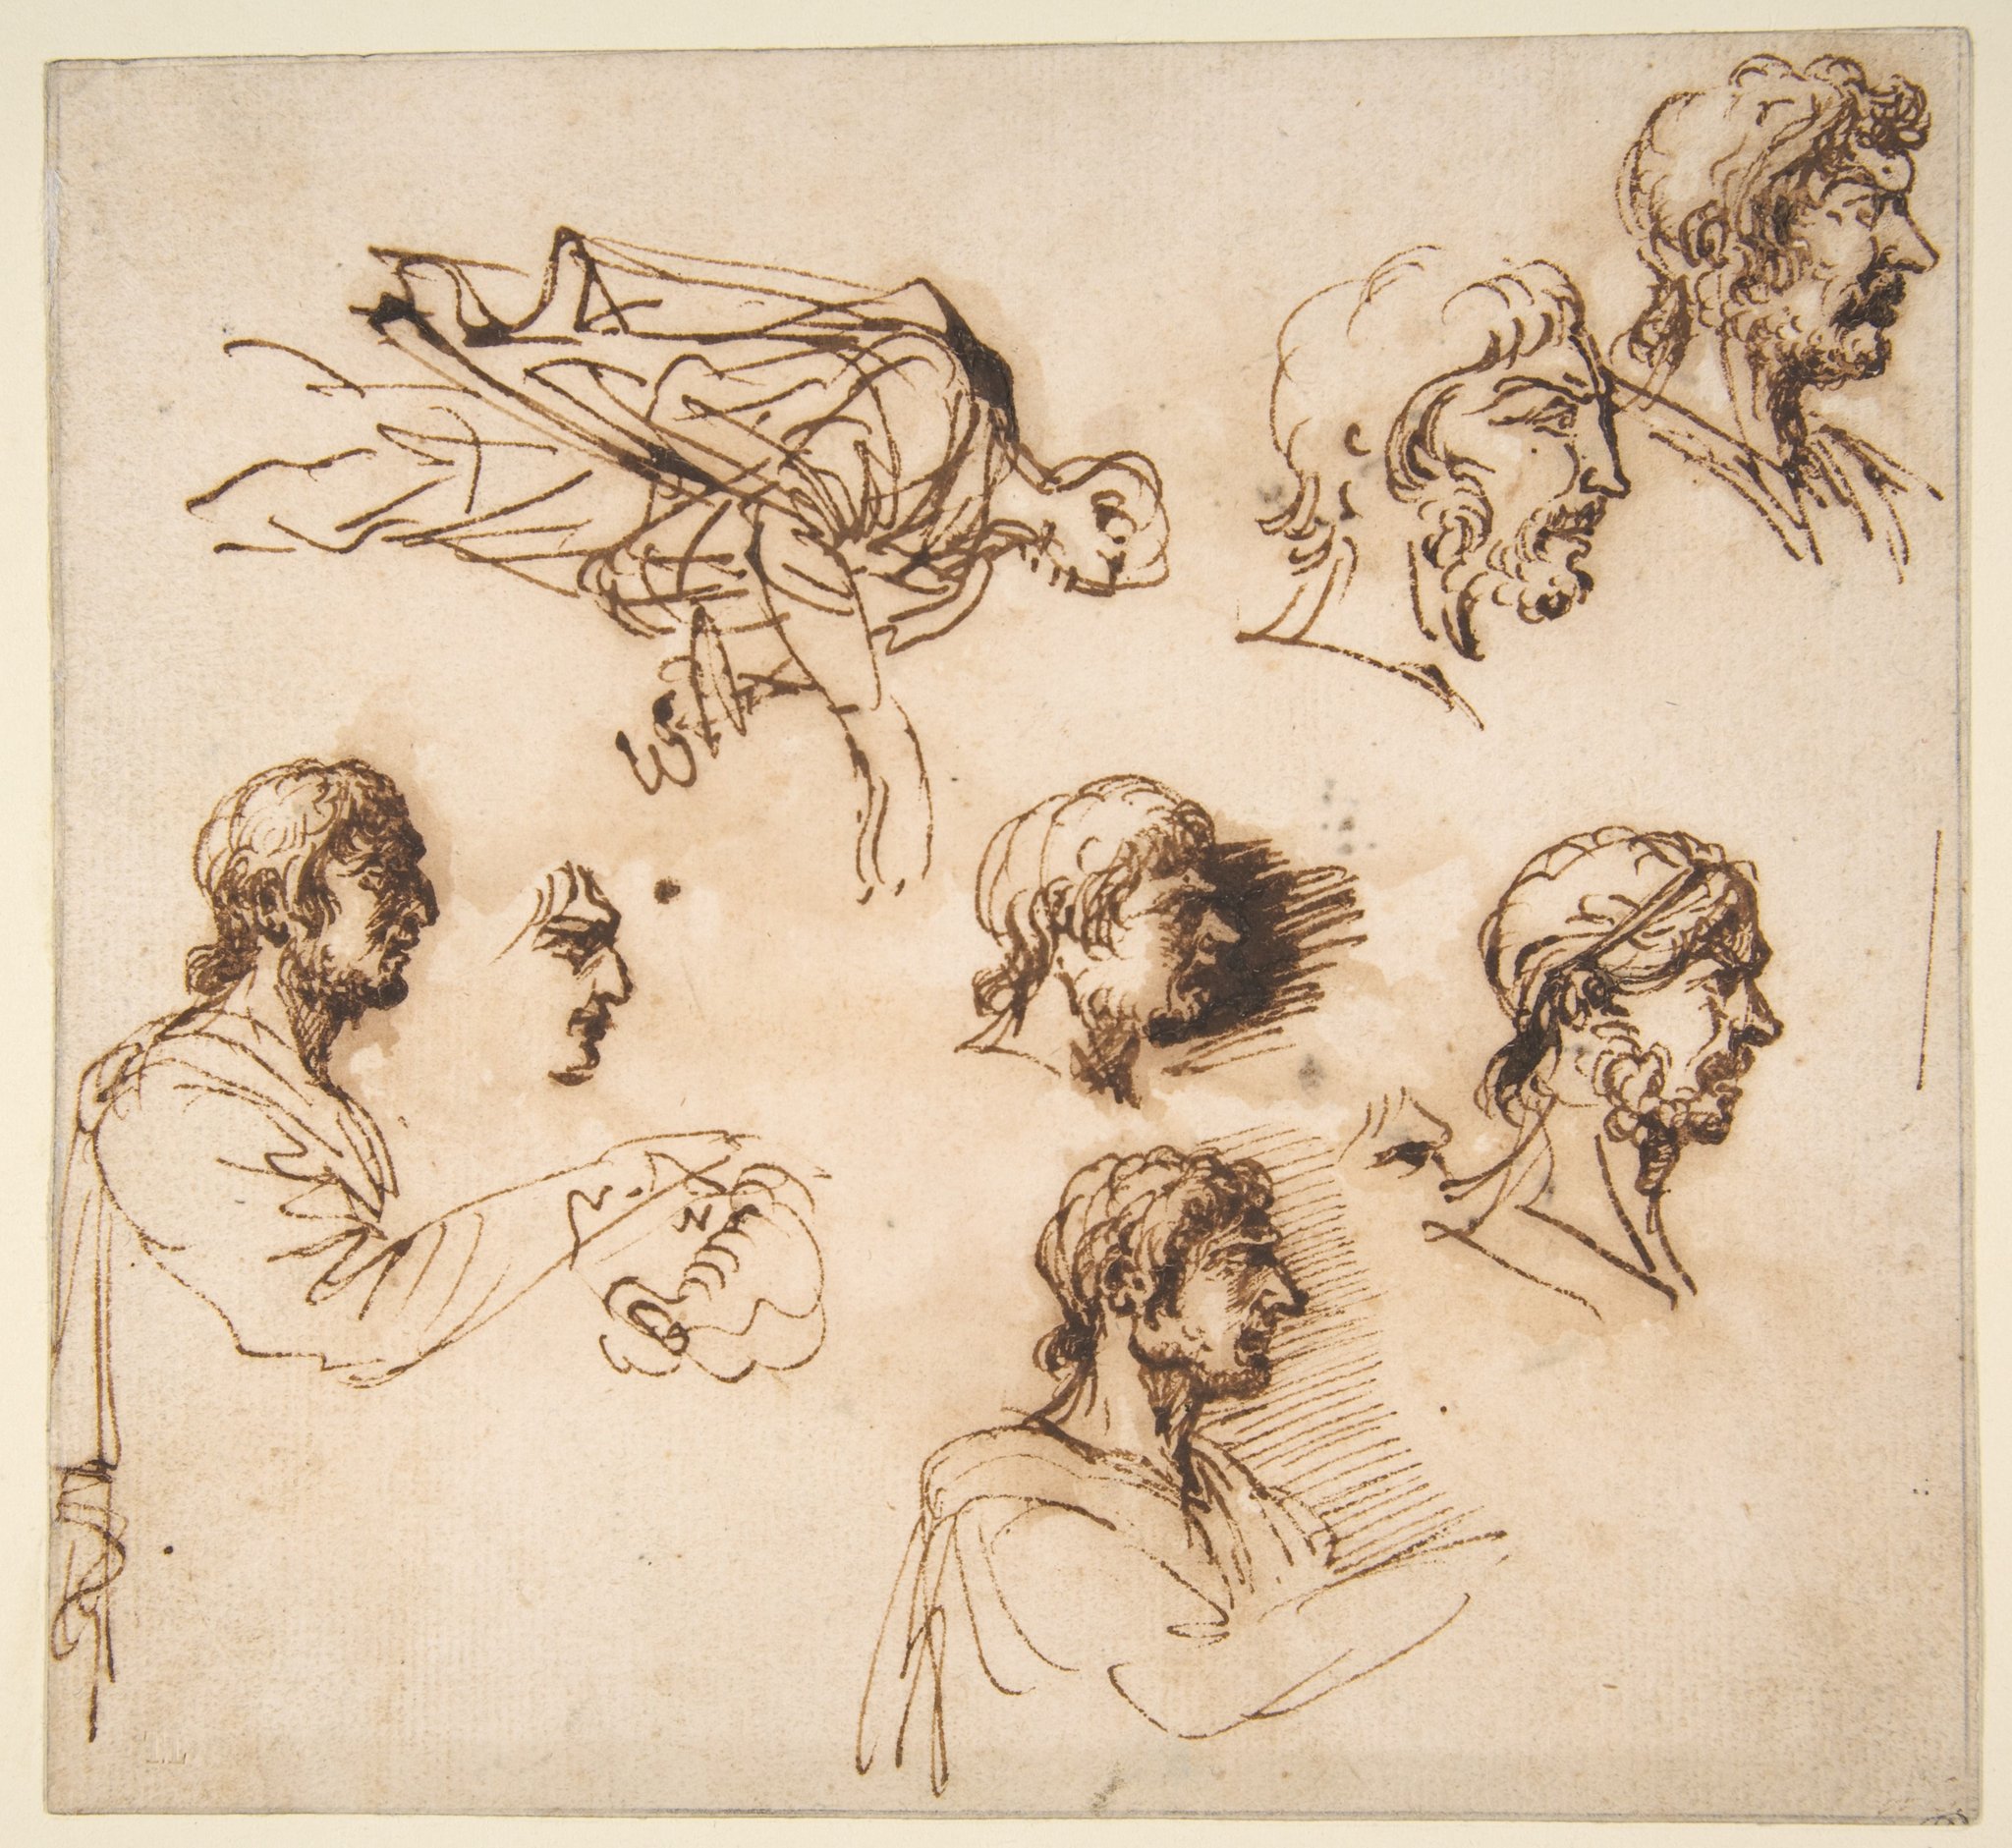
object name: drawing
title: Studies of a Man's Head in Profile, and of a Standing Male Figure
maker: salvator rosa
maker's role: artist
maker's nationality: italian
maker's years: 1615-1673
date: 1615-1673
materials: ink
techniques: pen, wash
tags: heads,men,profiles